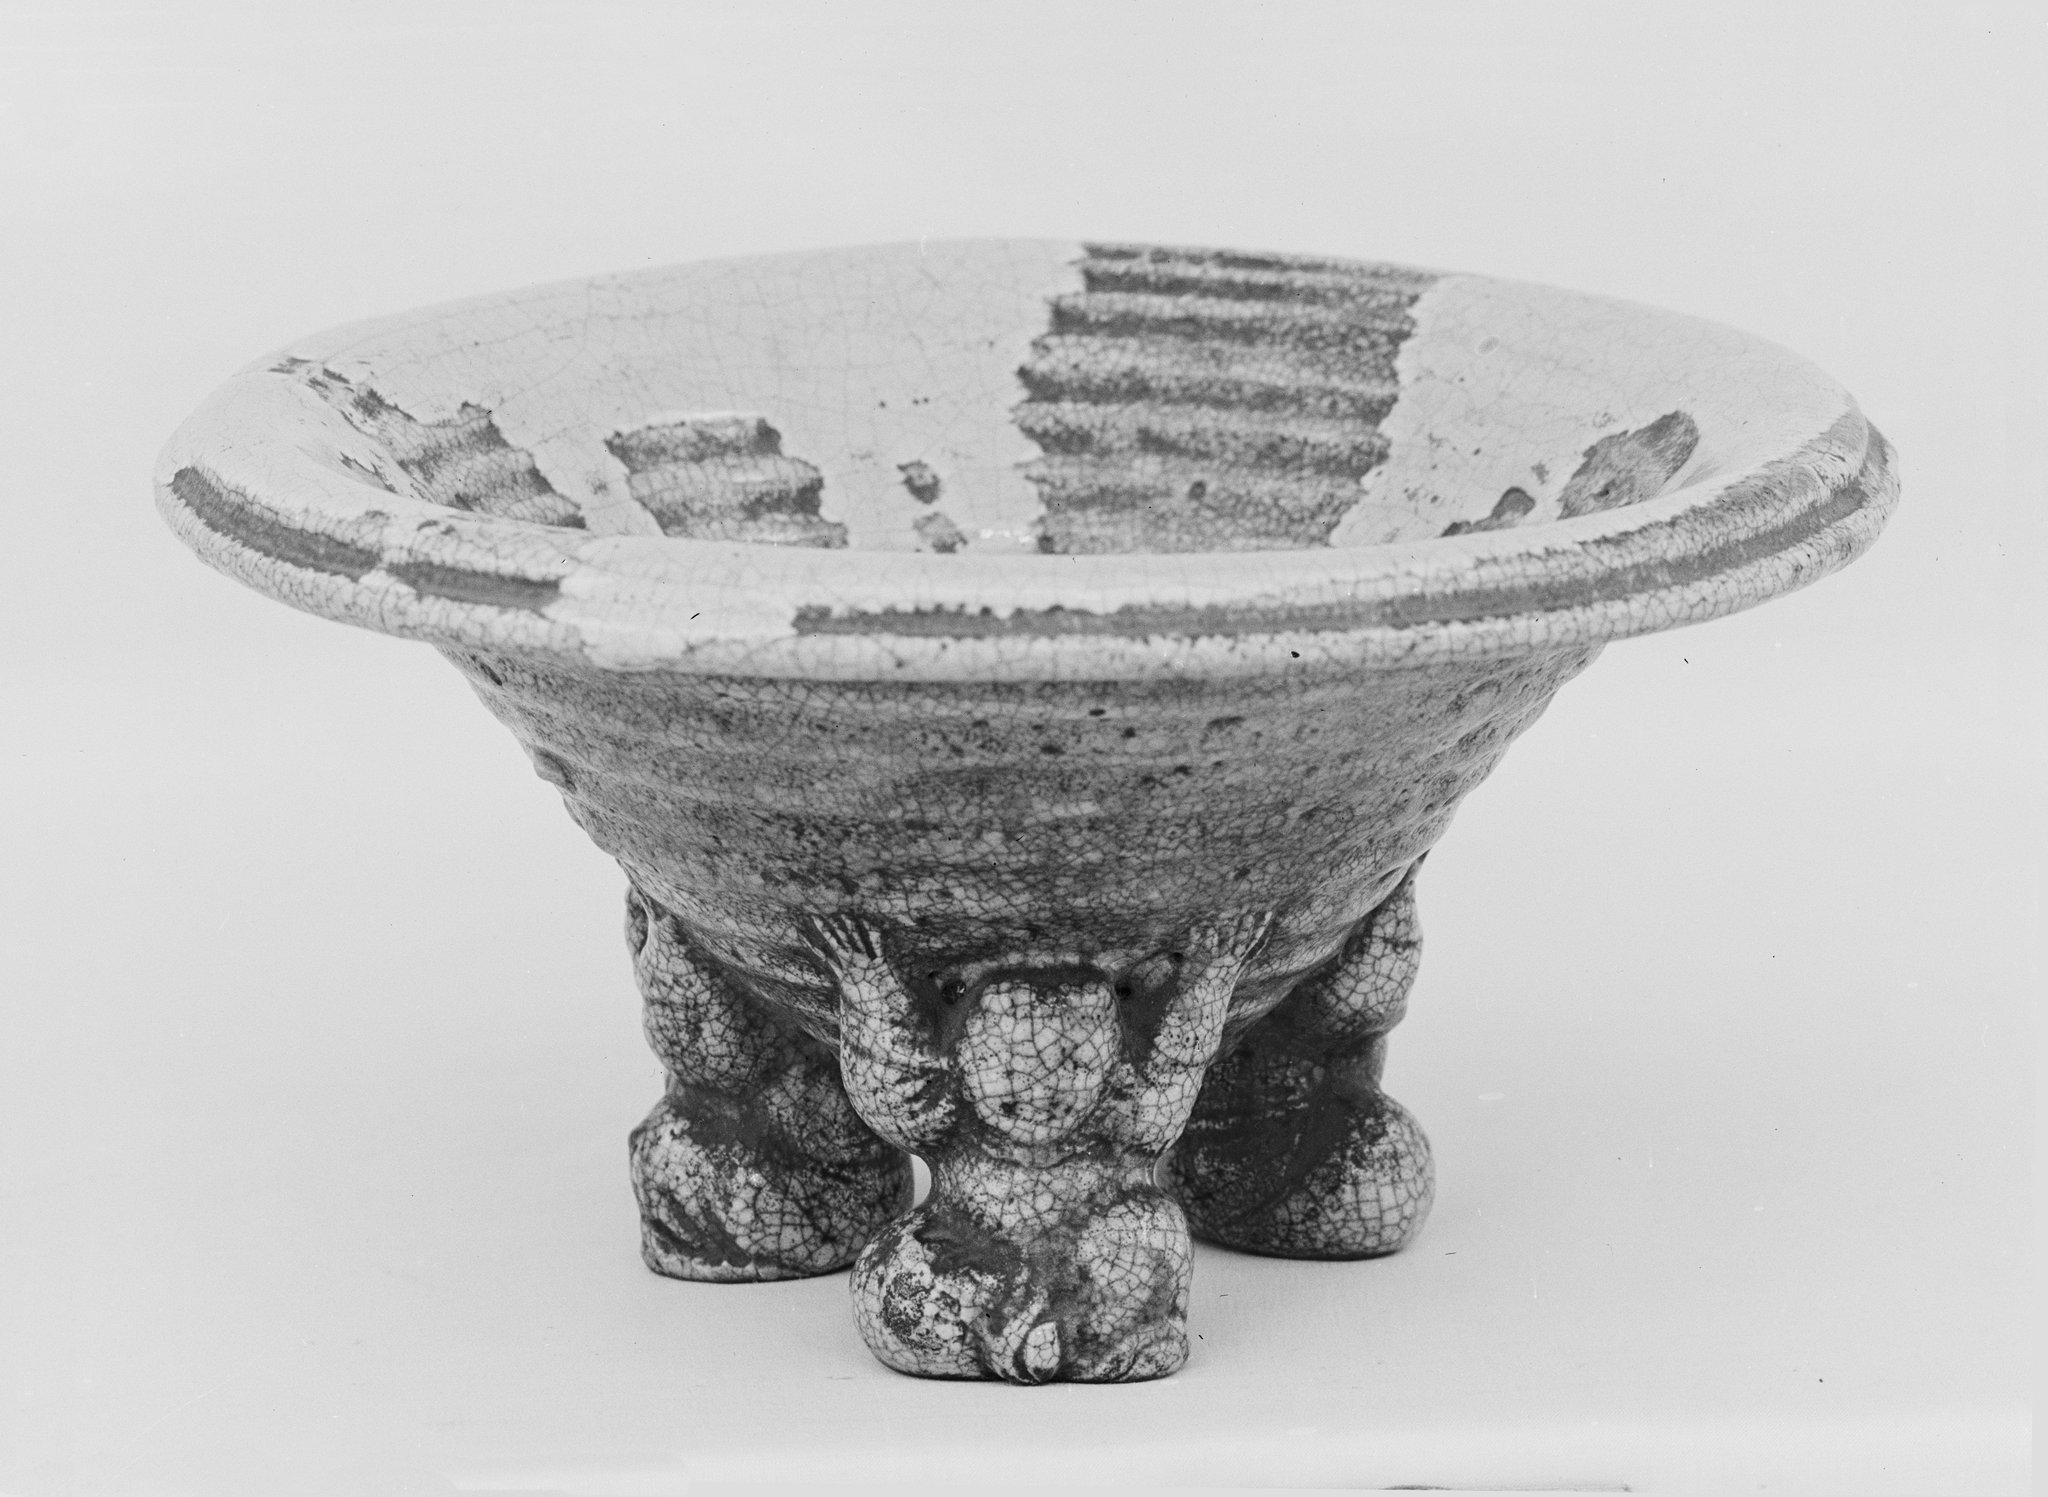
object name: cake dish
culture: japanese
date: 1701-1800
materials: clay, glaze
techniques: overglaze